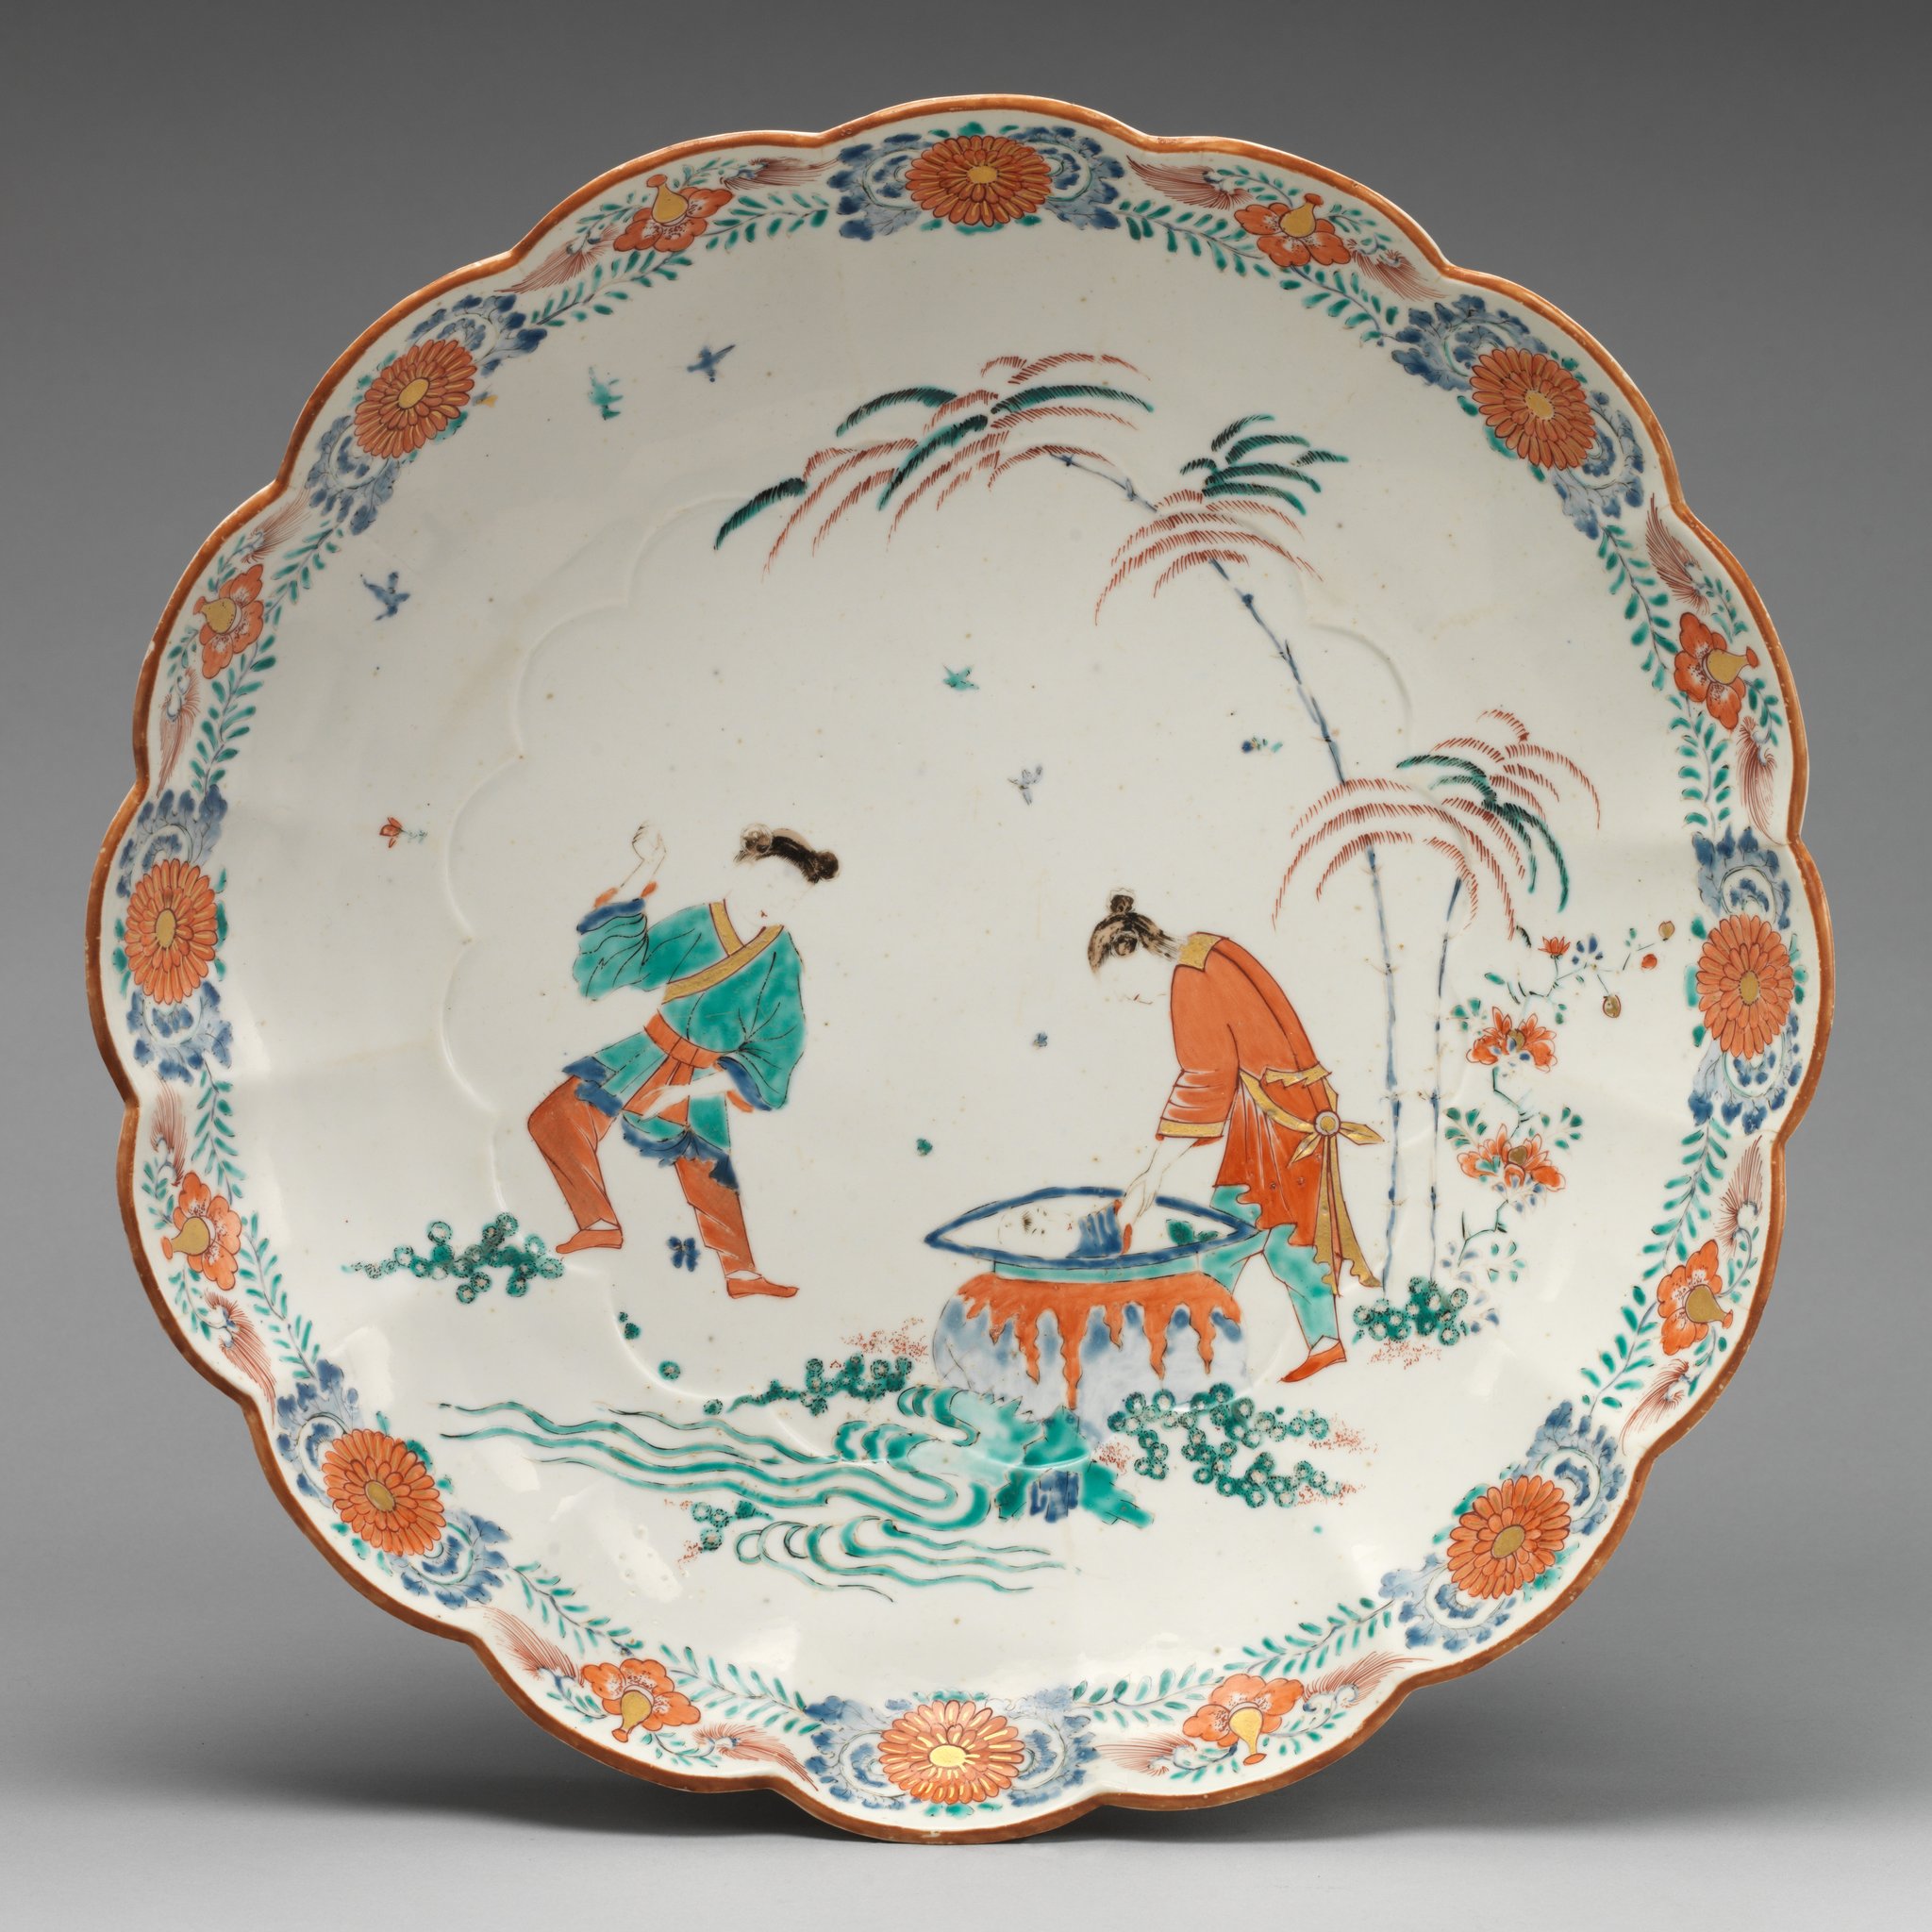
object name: plate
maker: chelsea porcelain manufactory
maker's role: factory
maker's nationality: british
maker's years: 1744-1784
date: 1752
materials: soft paste porcelain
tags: men,flowers,trees